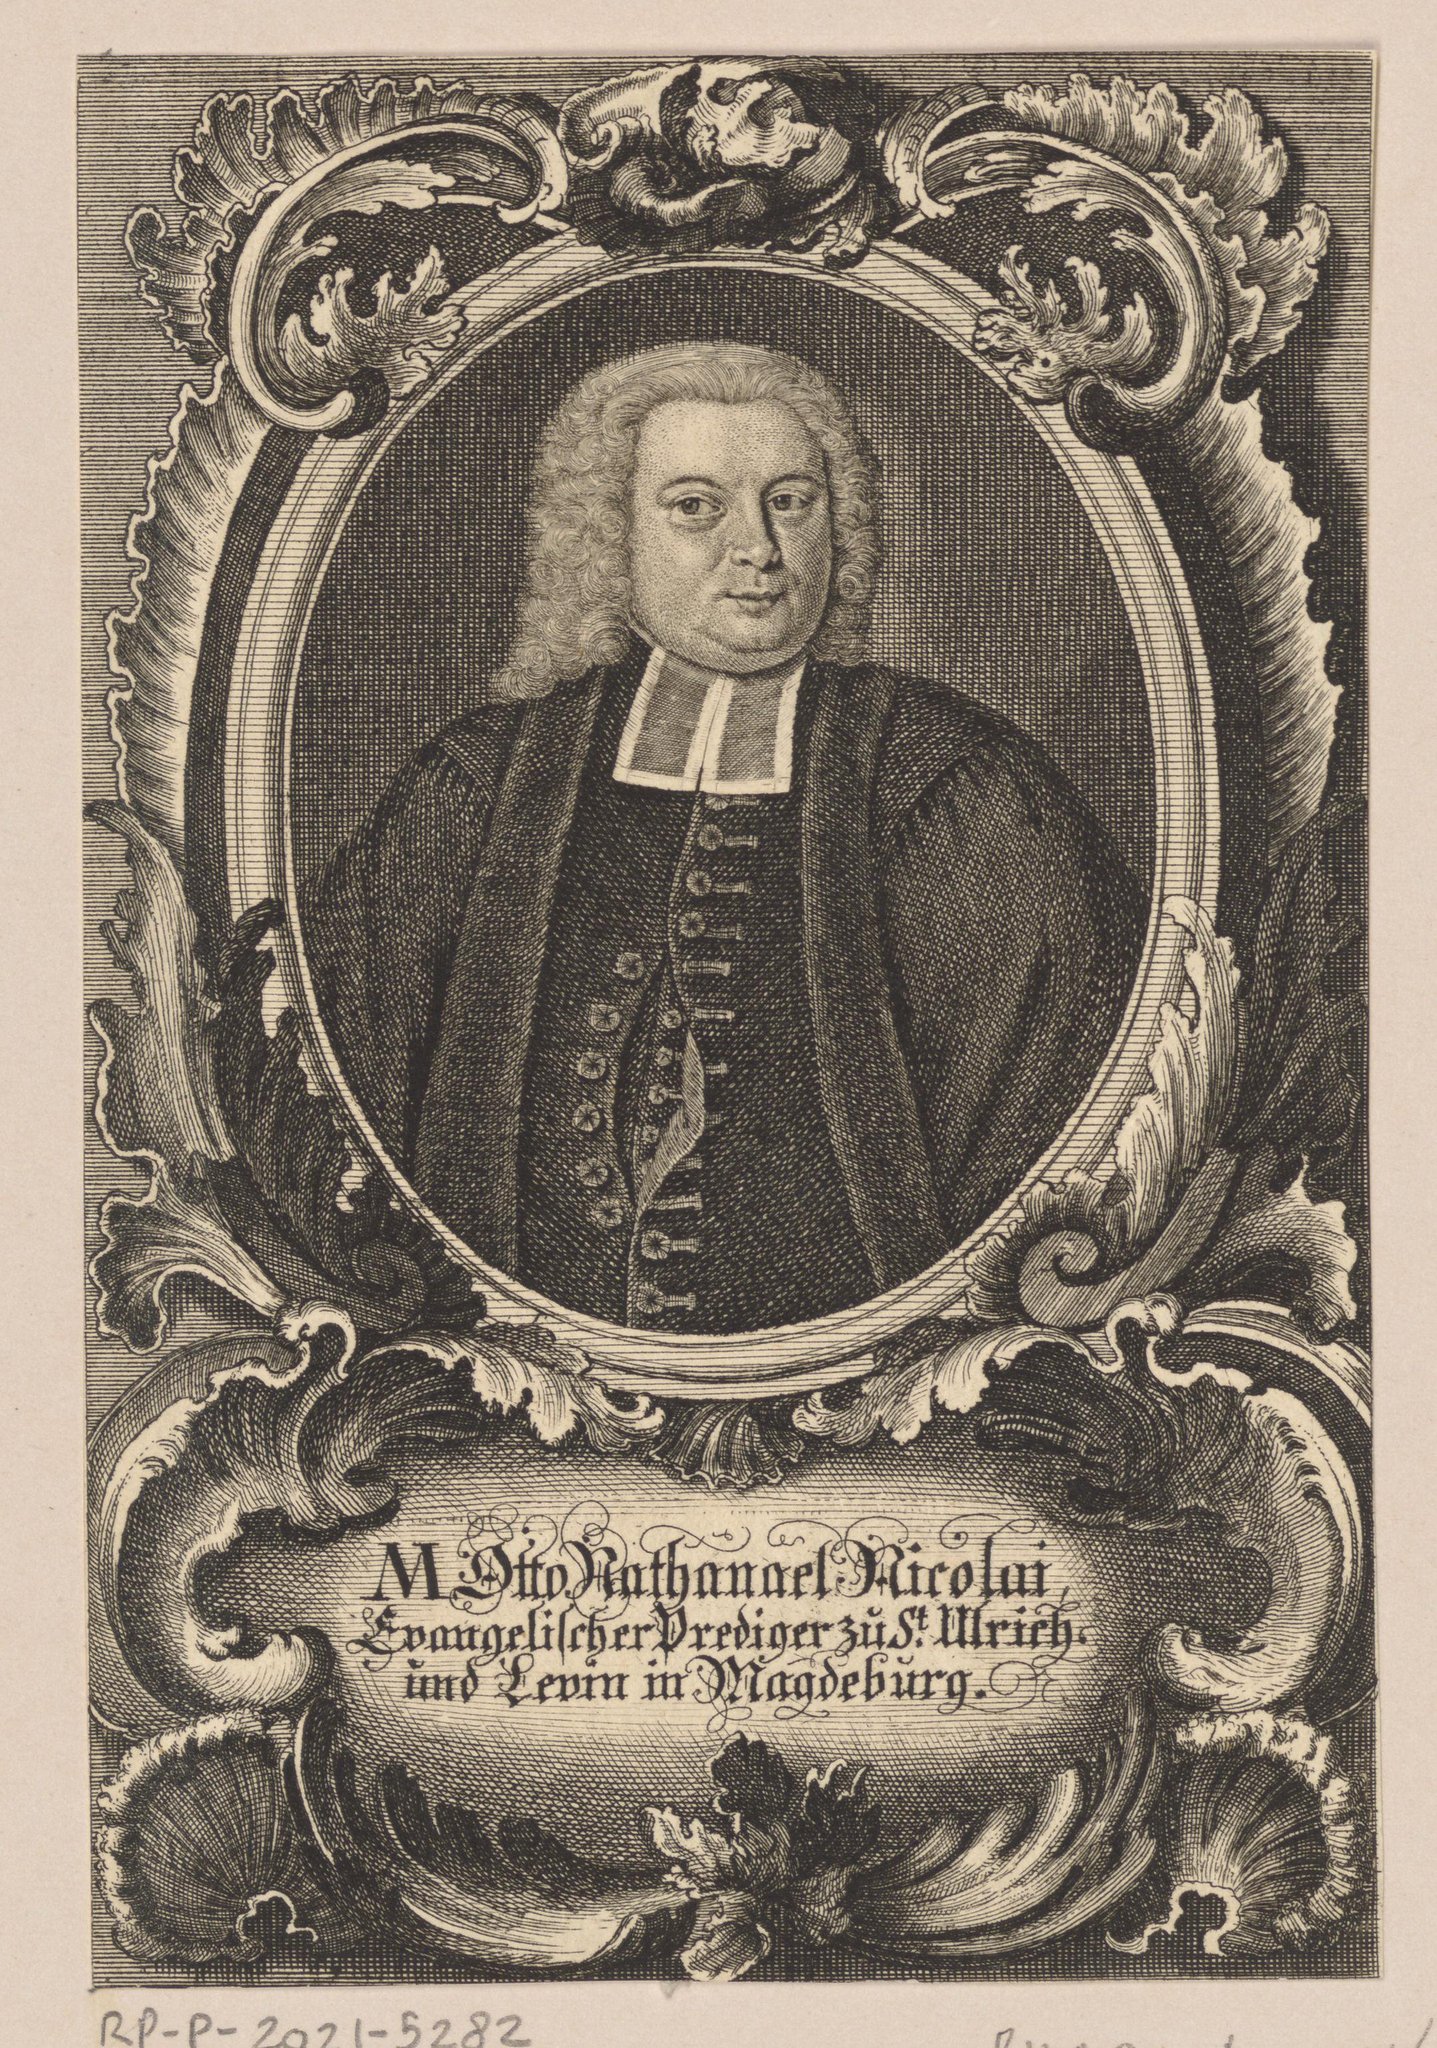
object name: print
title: Portret van Otto Nathanael Nicolai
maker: Anonymous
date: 1742-1799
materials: paper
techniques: engraving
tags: otto nathanael nicolai, the christian churches, historical persons